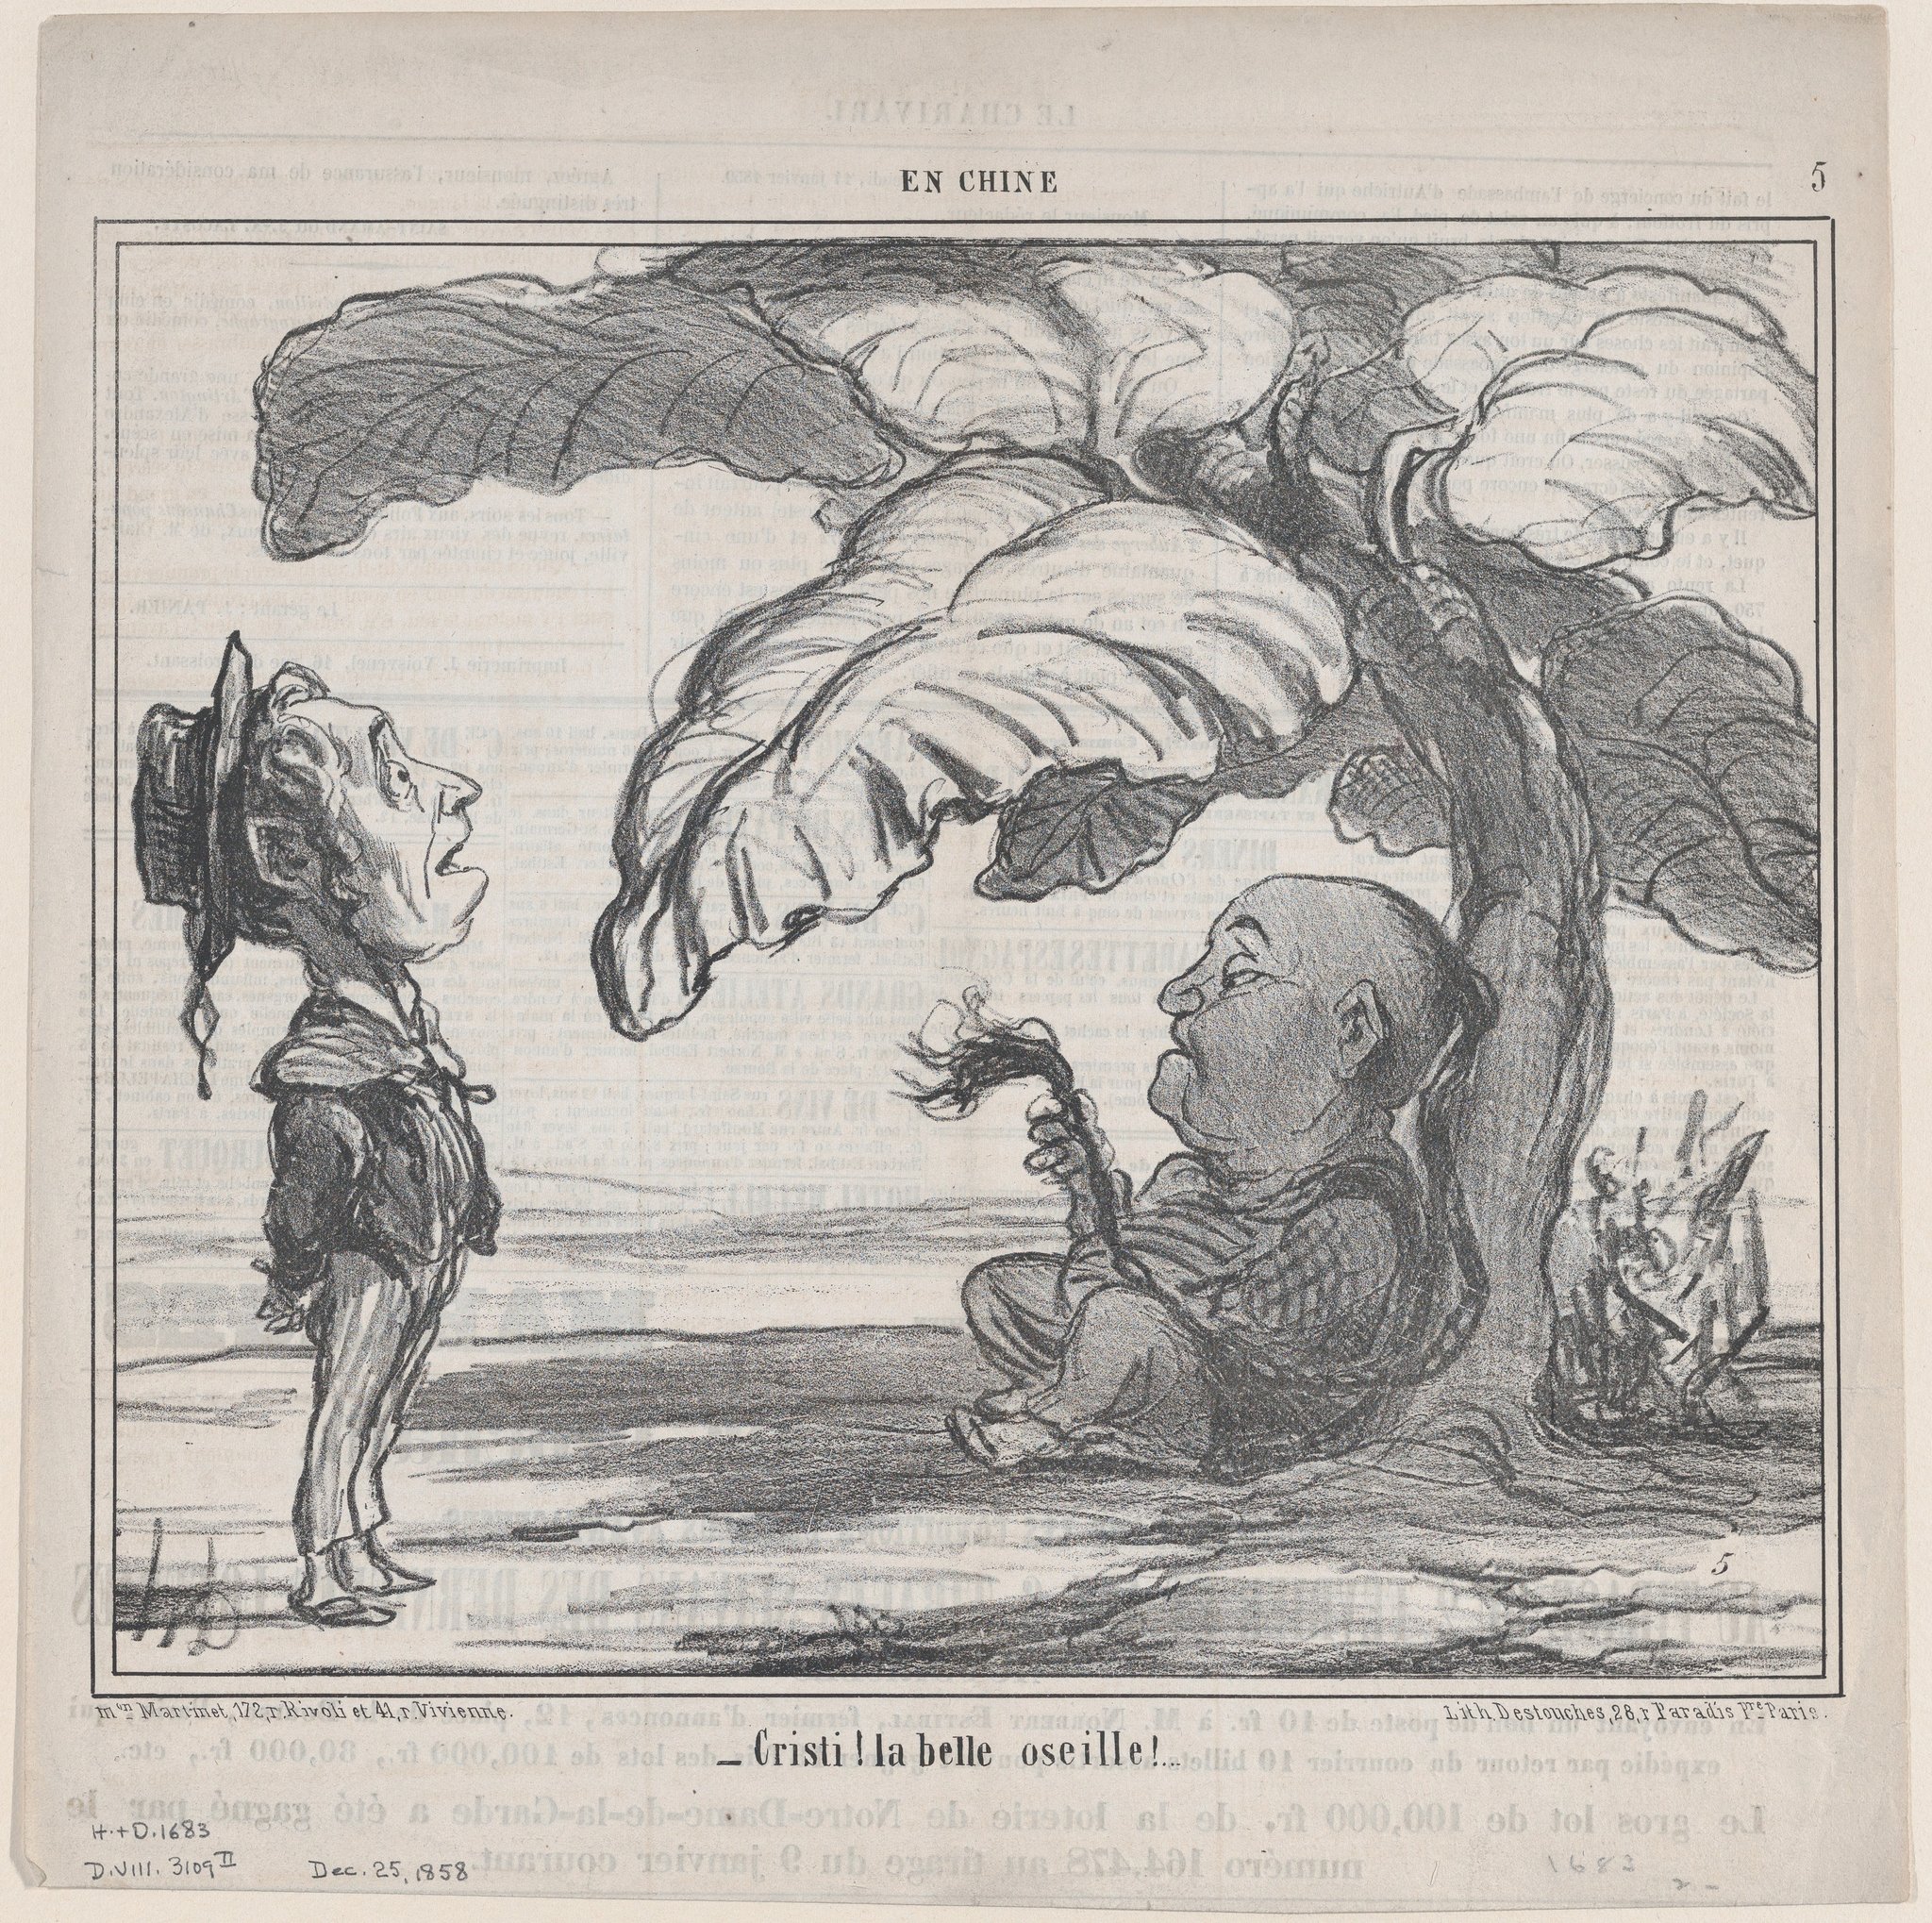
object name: print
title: Cristi! la belle oseille!, from "En Chine"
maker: honoré daumier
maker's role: artist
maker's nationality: french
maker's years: 1808-1879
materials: paper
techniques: lithograph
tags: men,trees